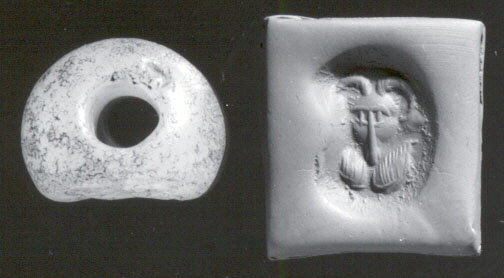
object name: stamp seal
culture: sasanian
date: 201-700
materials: stone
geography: iran or mesopotamia